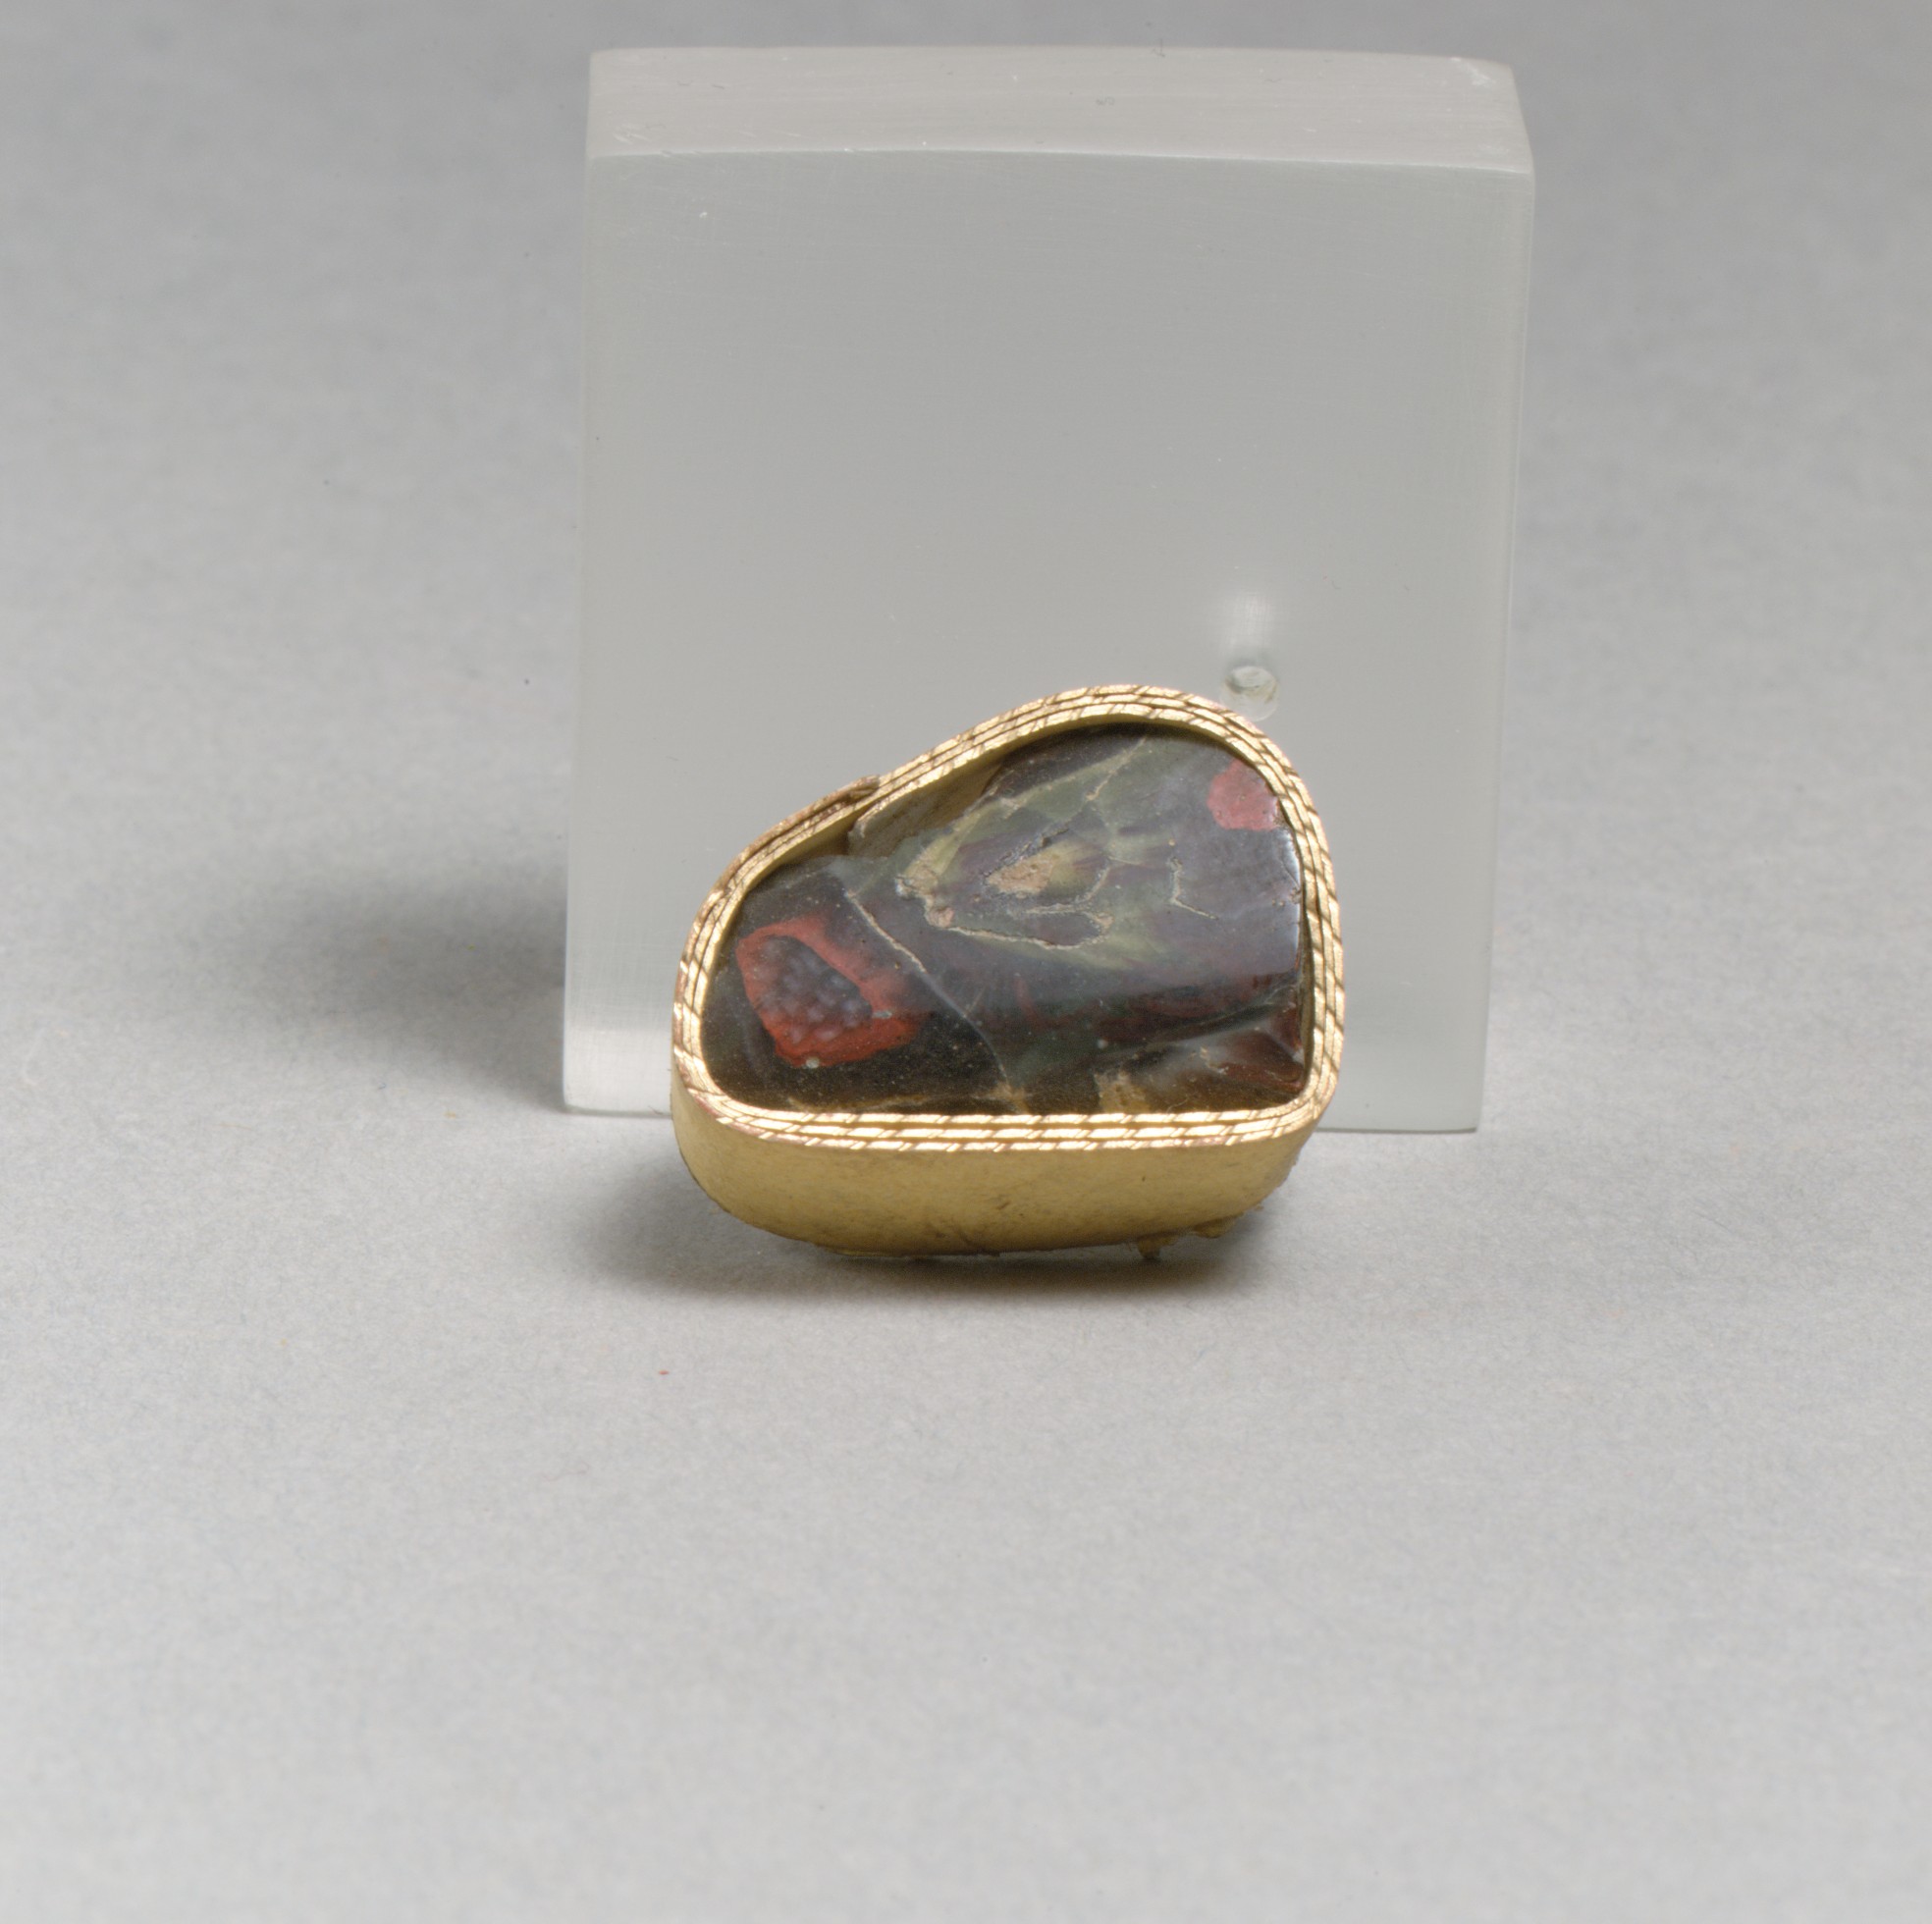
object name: fragment, mosaic bowl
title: Glass mosaic carinated bowl fragment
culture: roman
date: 34 BCE-33 CE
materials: glass